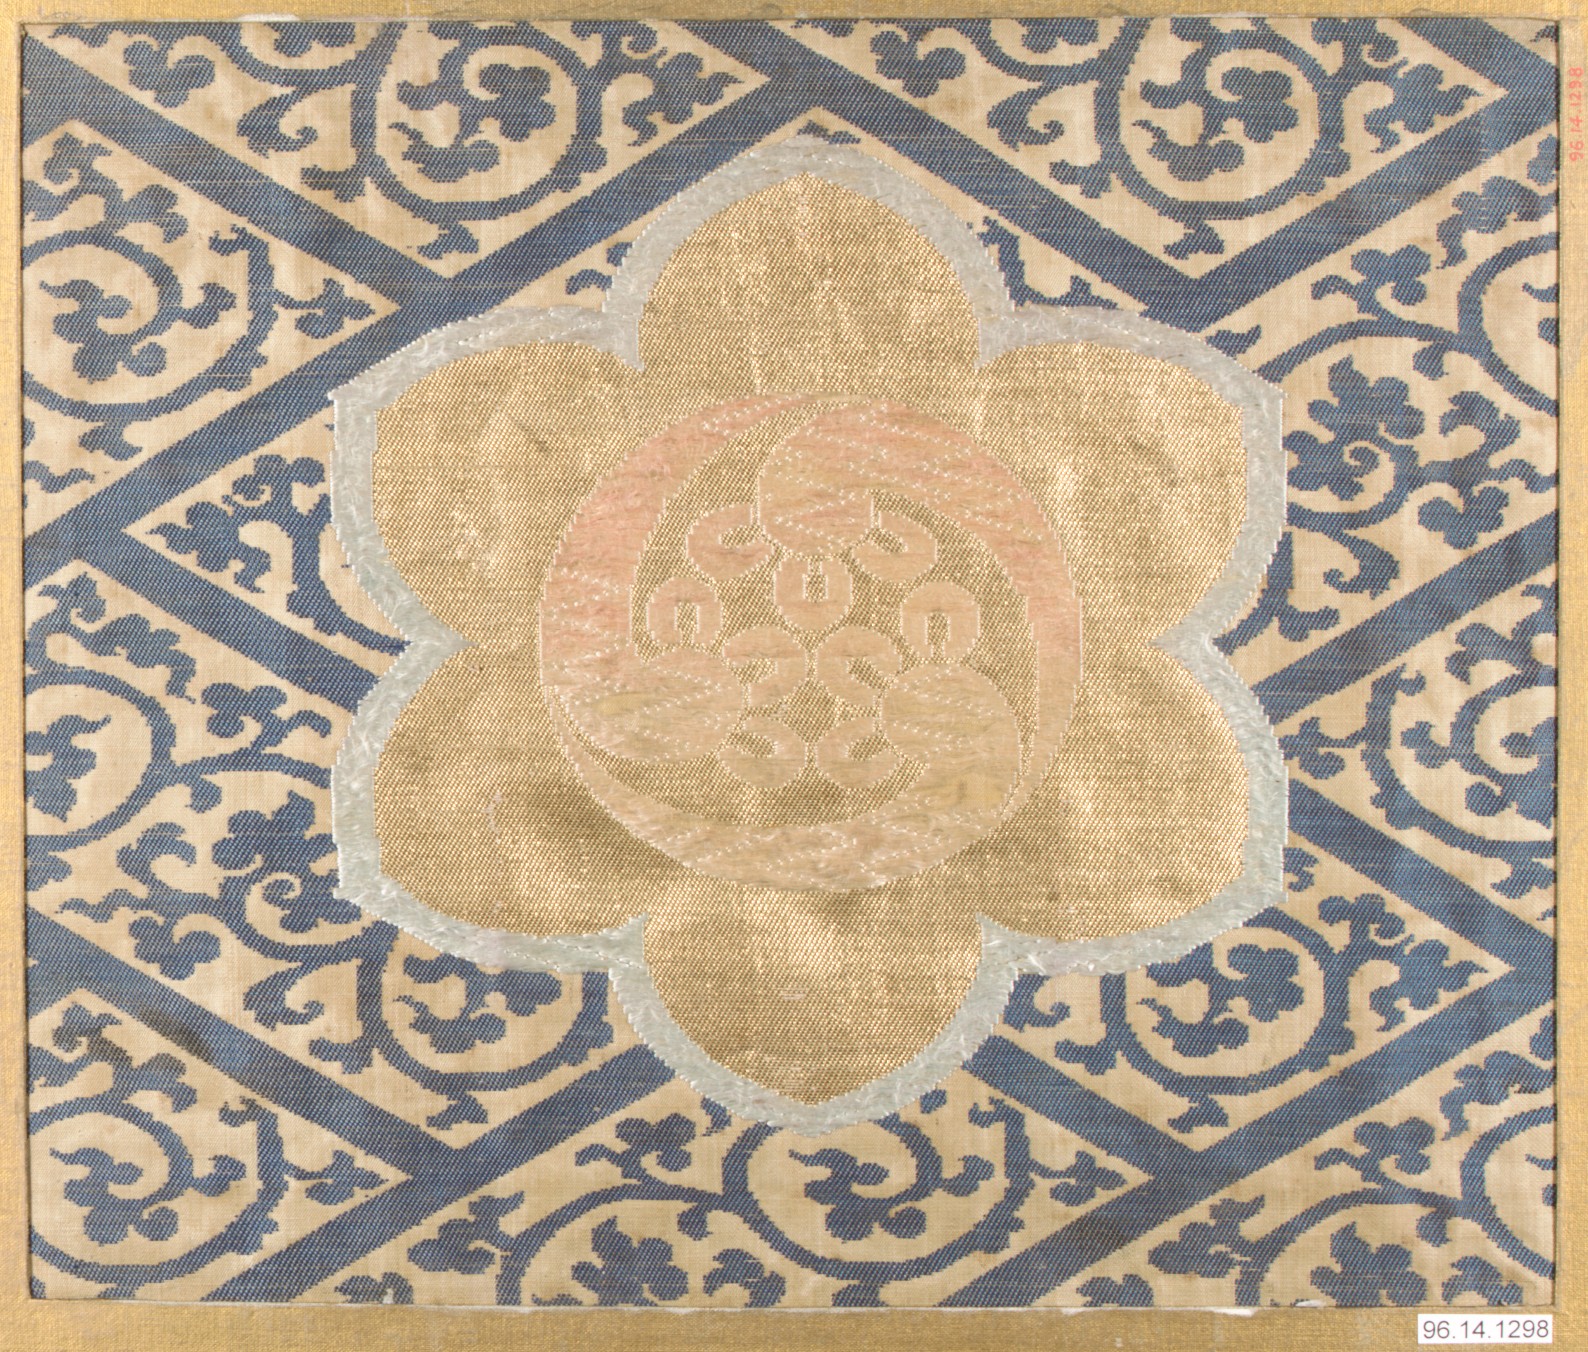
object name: piece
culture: japanese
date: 1701-1900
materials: silk